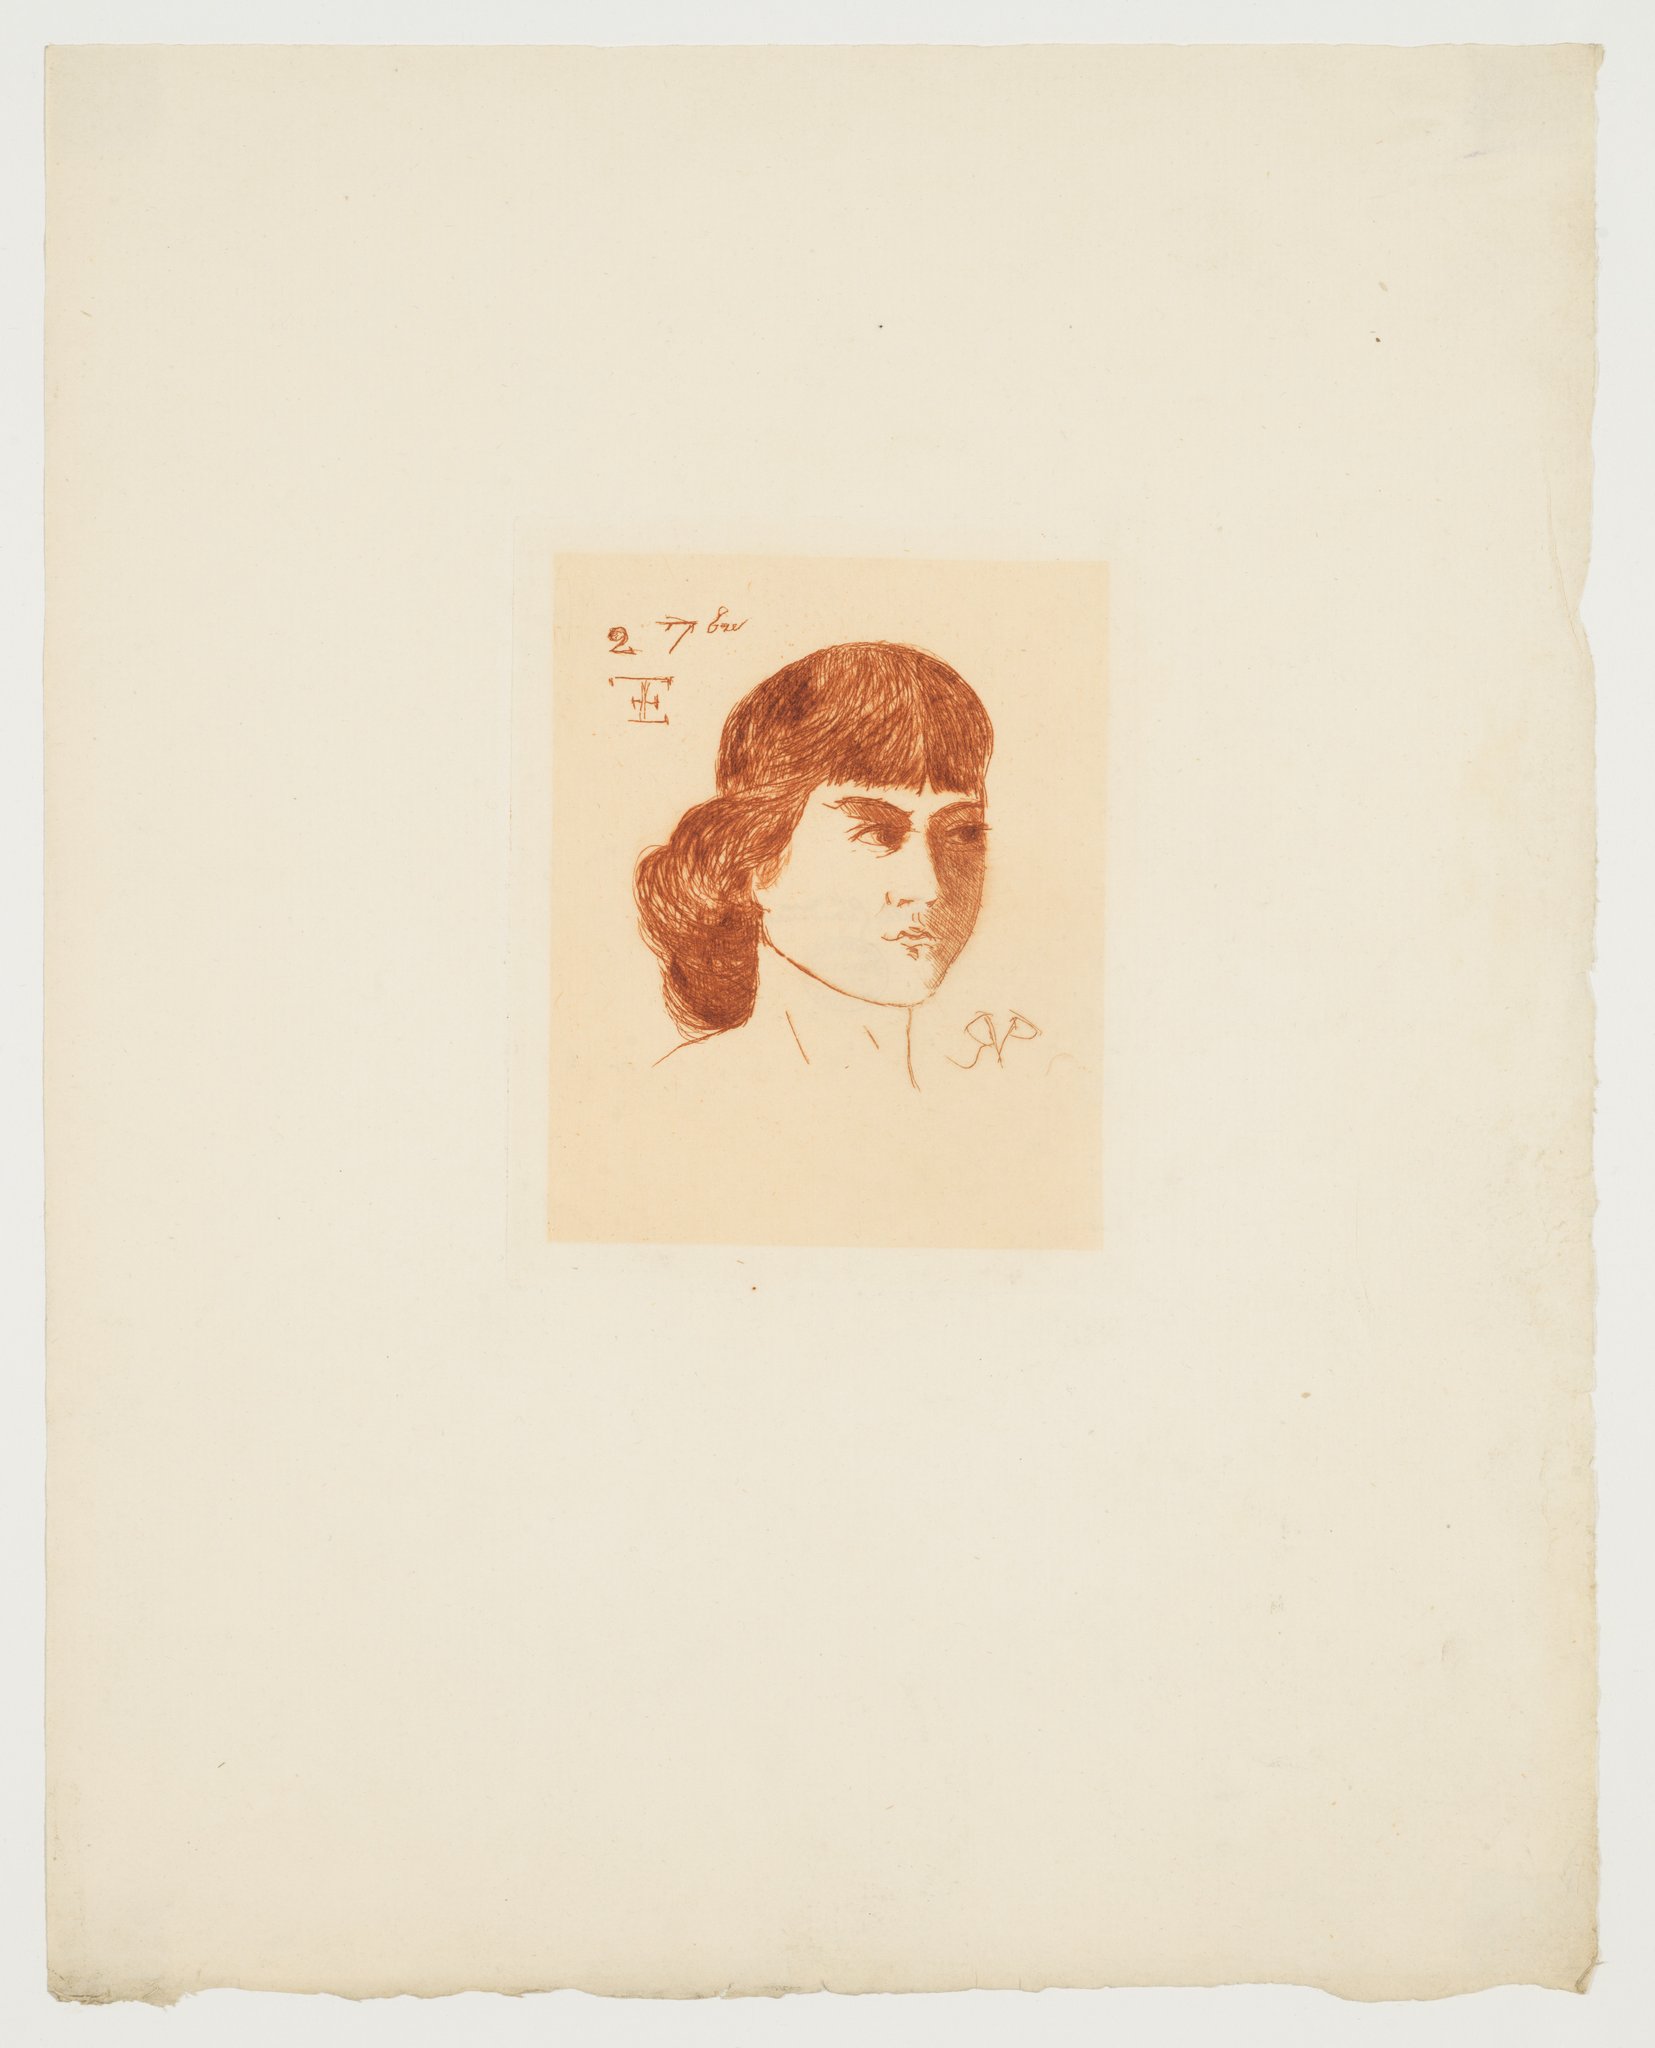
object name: print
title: Head of a Woman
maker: dr. paul gachet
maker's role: artist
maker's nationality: french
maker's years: 1828-1909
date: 1859-1889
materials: ink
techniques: drypoint, printing